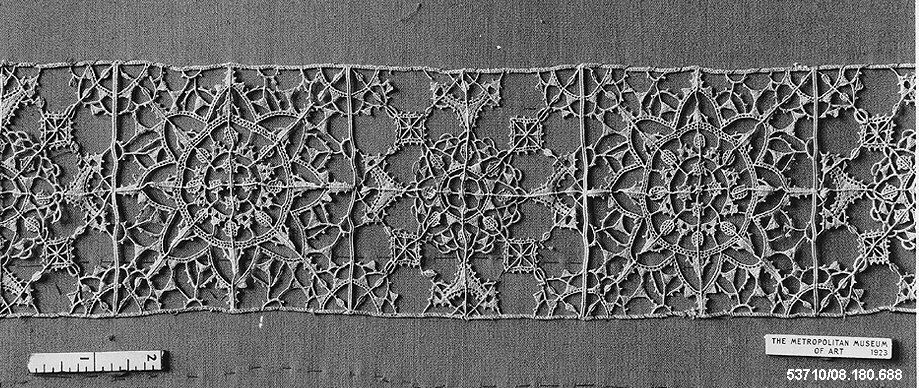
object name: border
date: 1801-1900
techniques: lace